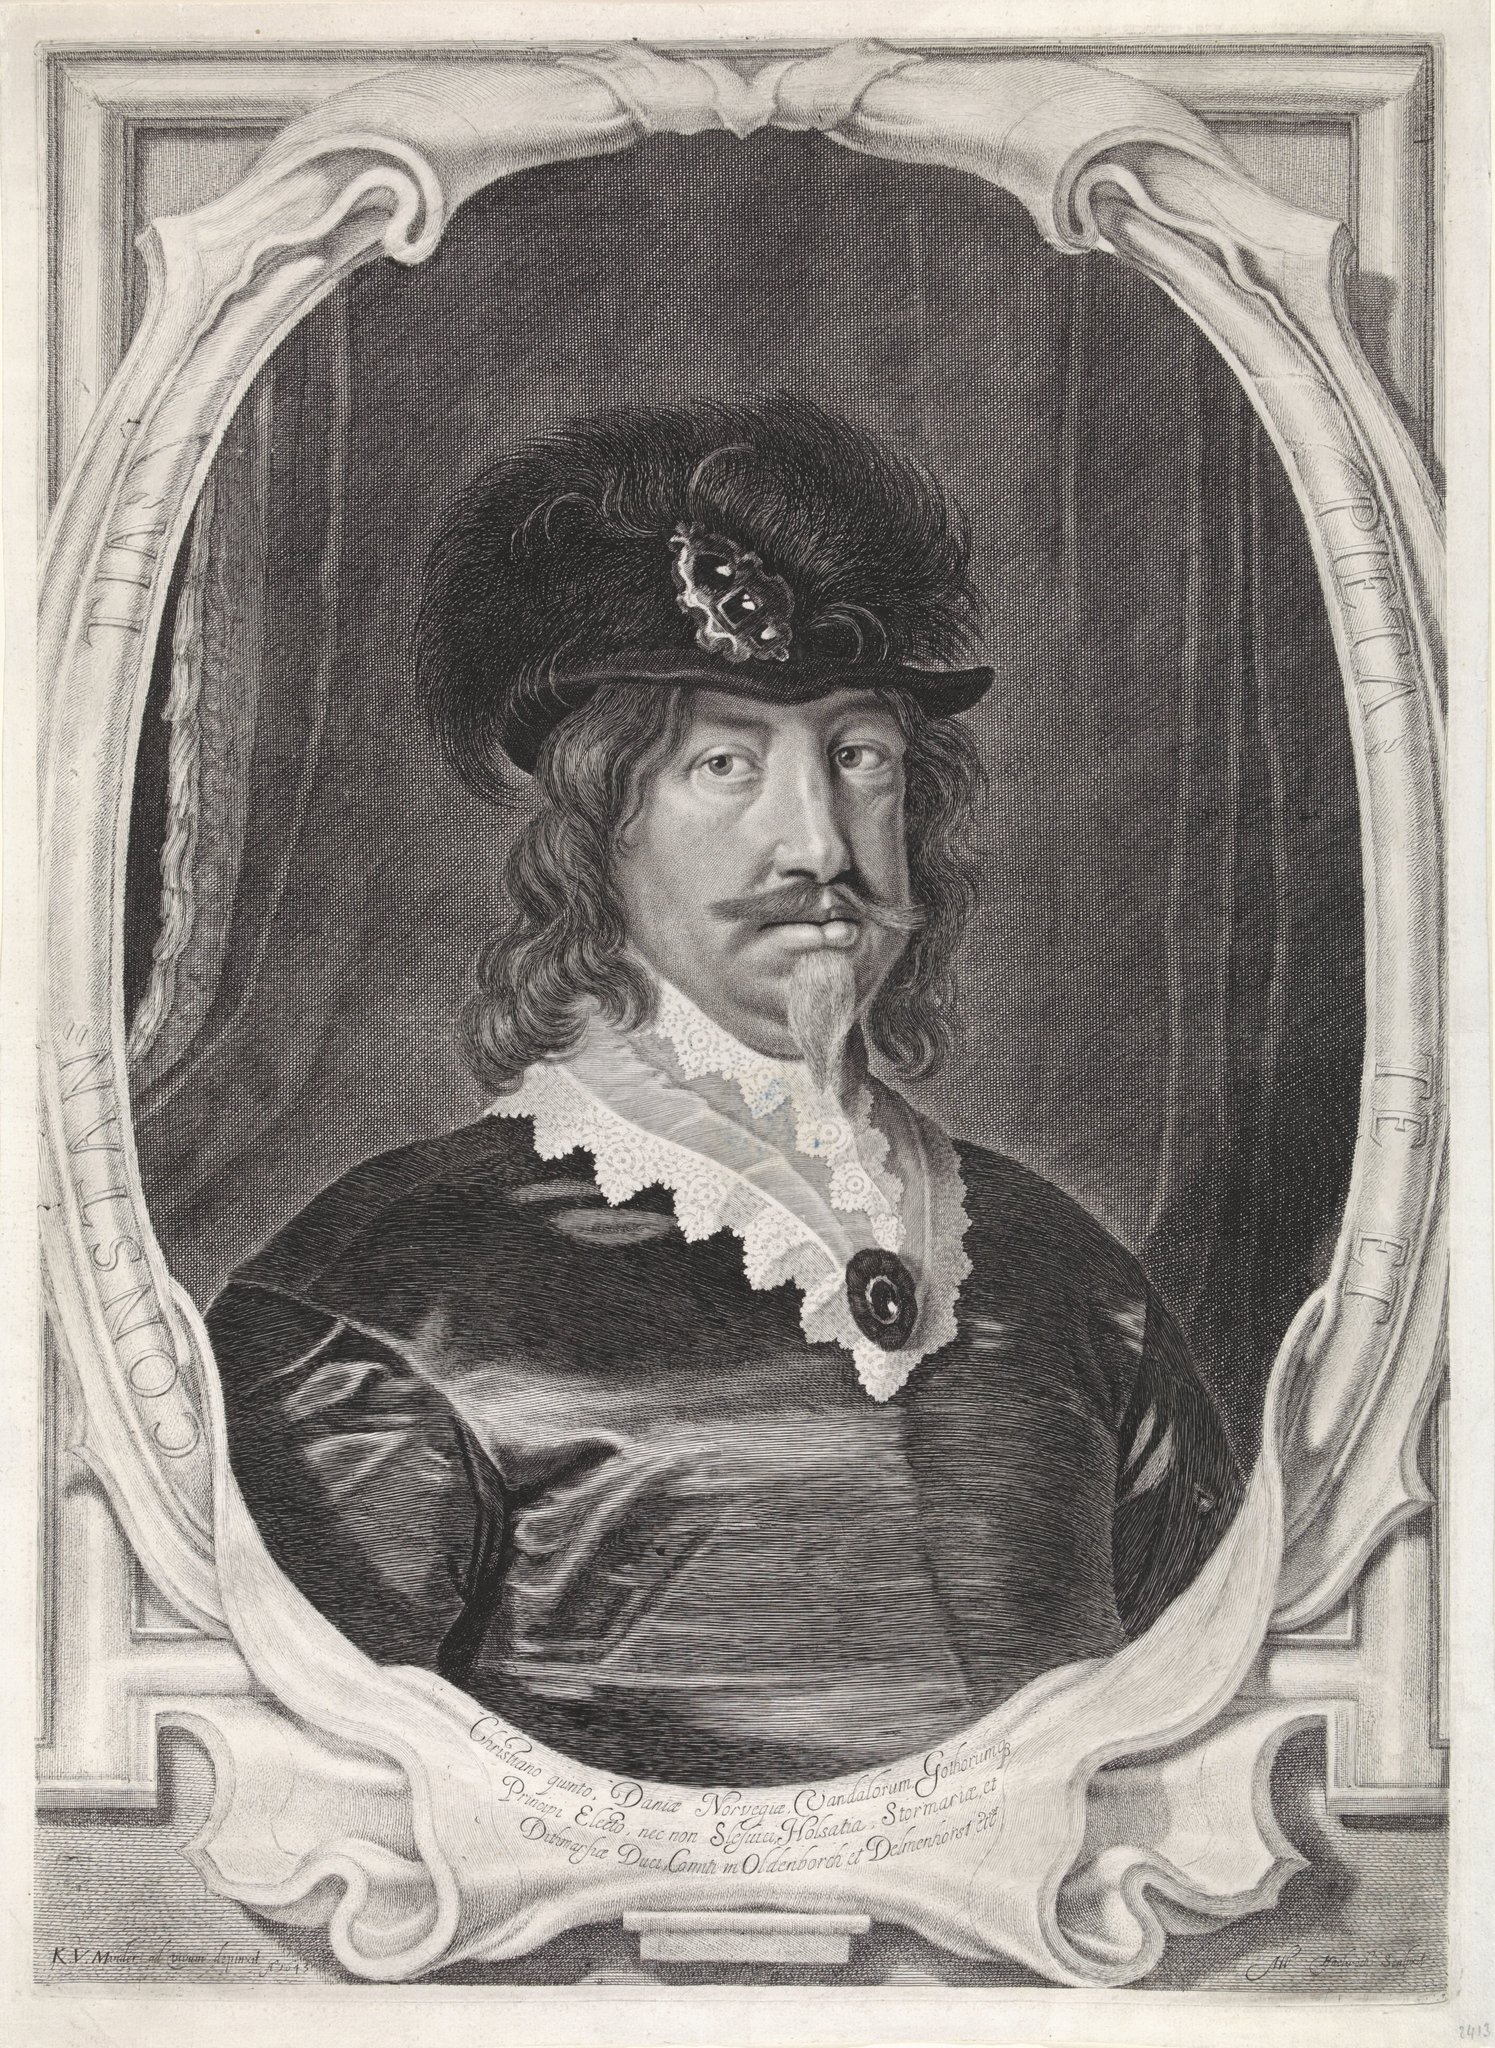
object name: print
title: Portret van Christiaan van Denemarken en Noorwegen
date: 1643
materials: paper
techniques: engraving, etching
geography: copenhagen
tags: copenhagen (city), head-gear: hat (+ men's clothes)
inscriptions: collector's mark: Lugt 119, collector's mark: Lugt 1060, collector's mark: Lugt 654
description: Portret van Christiaan van Denemarken en Noorwegen, in een ovaal cartouche. Op zijn hoofd een hoed met een veer welke met een broche is vastgemaakt.